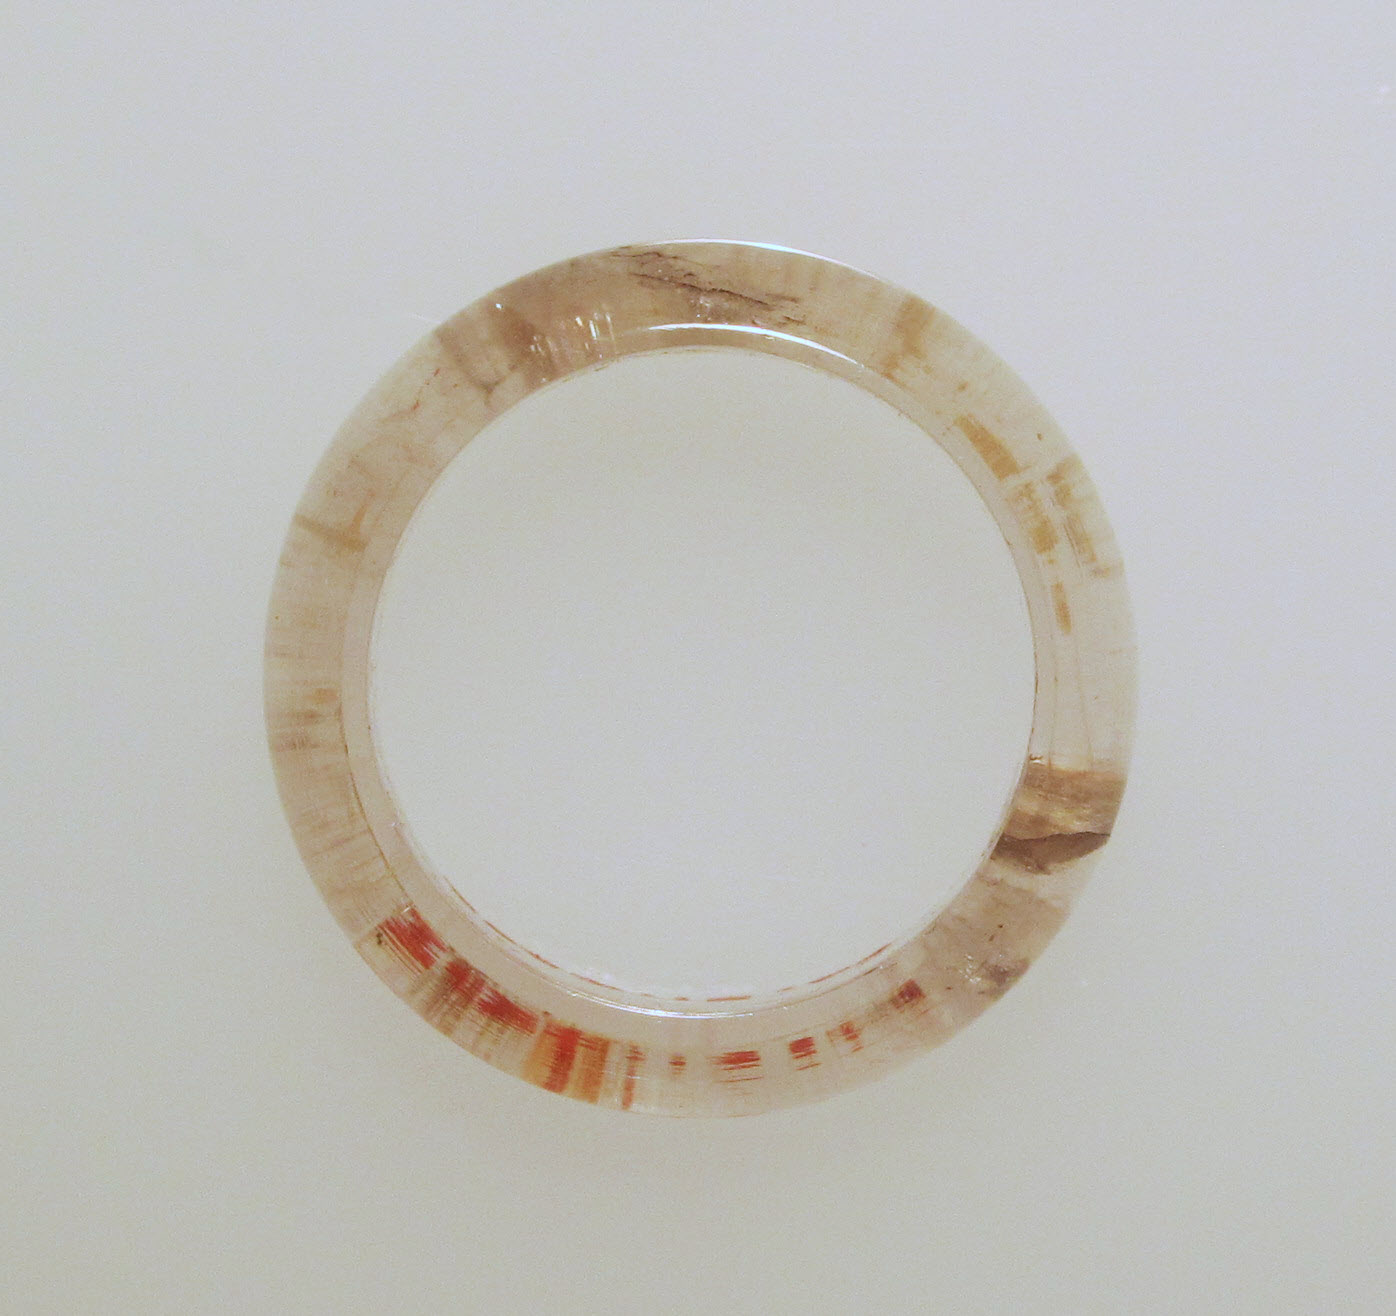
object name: ring with gold foil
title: Rock crystal ring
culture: roman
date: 1-200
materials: gold, quartz